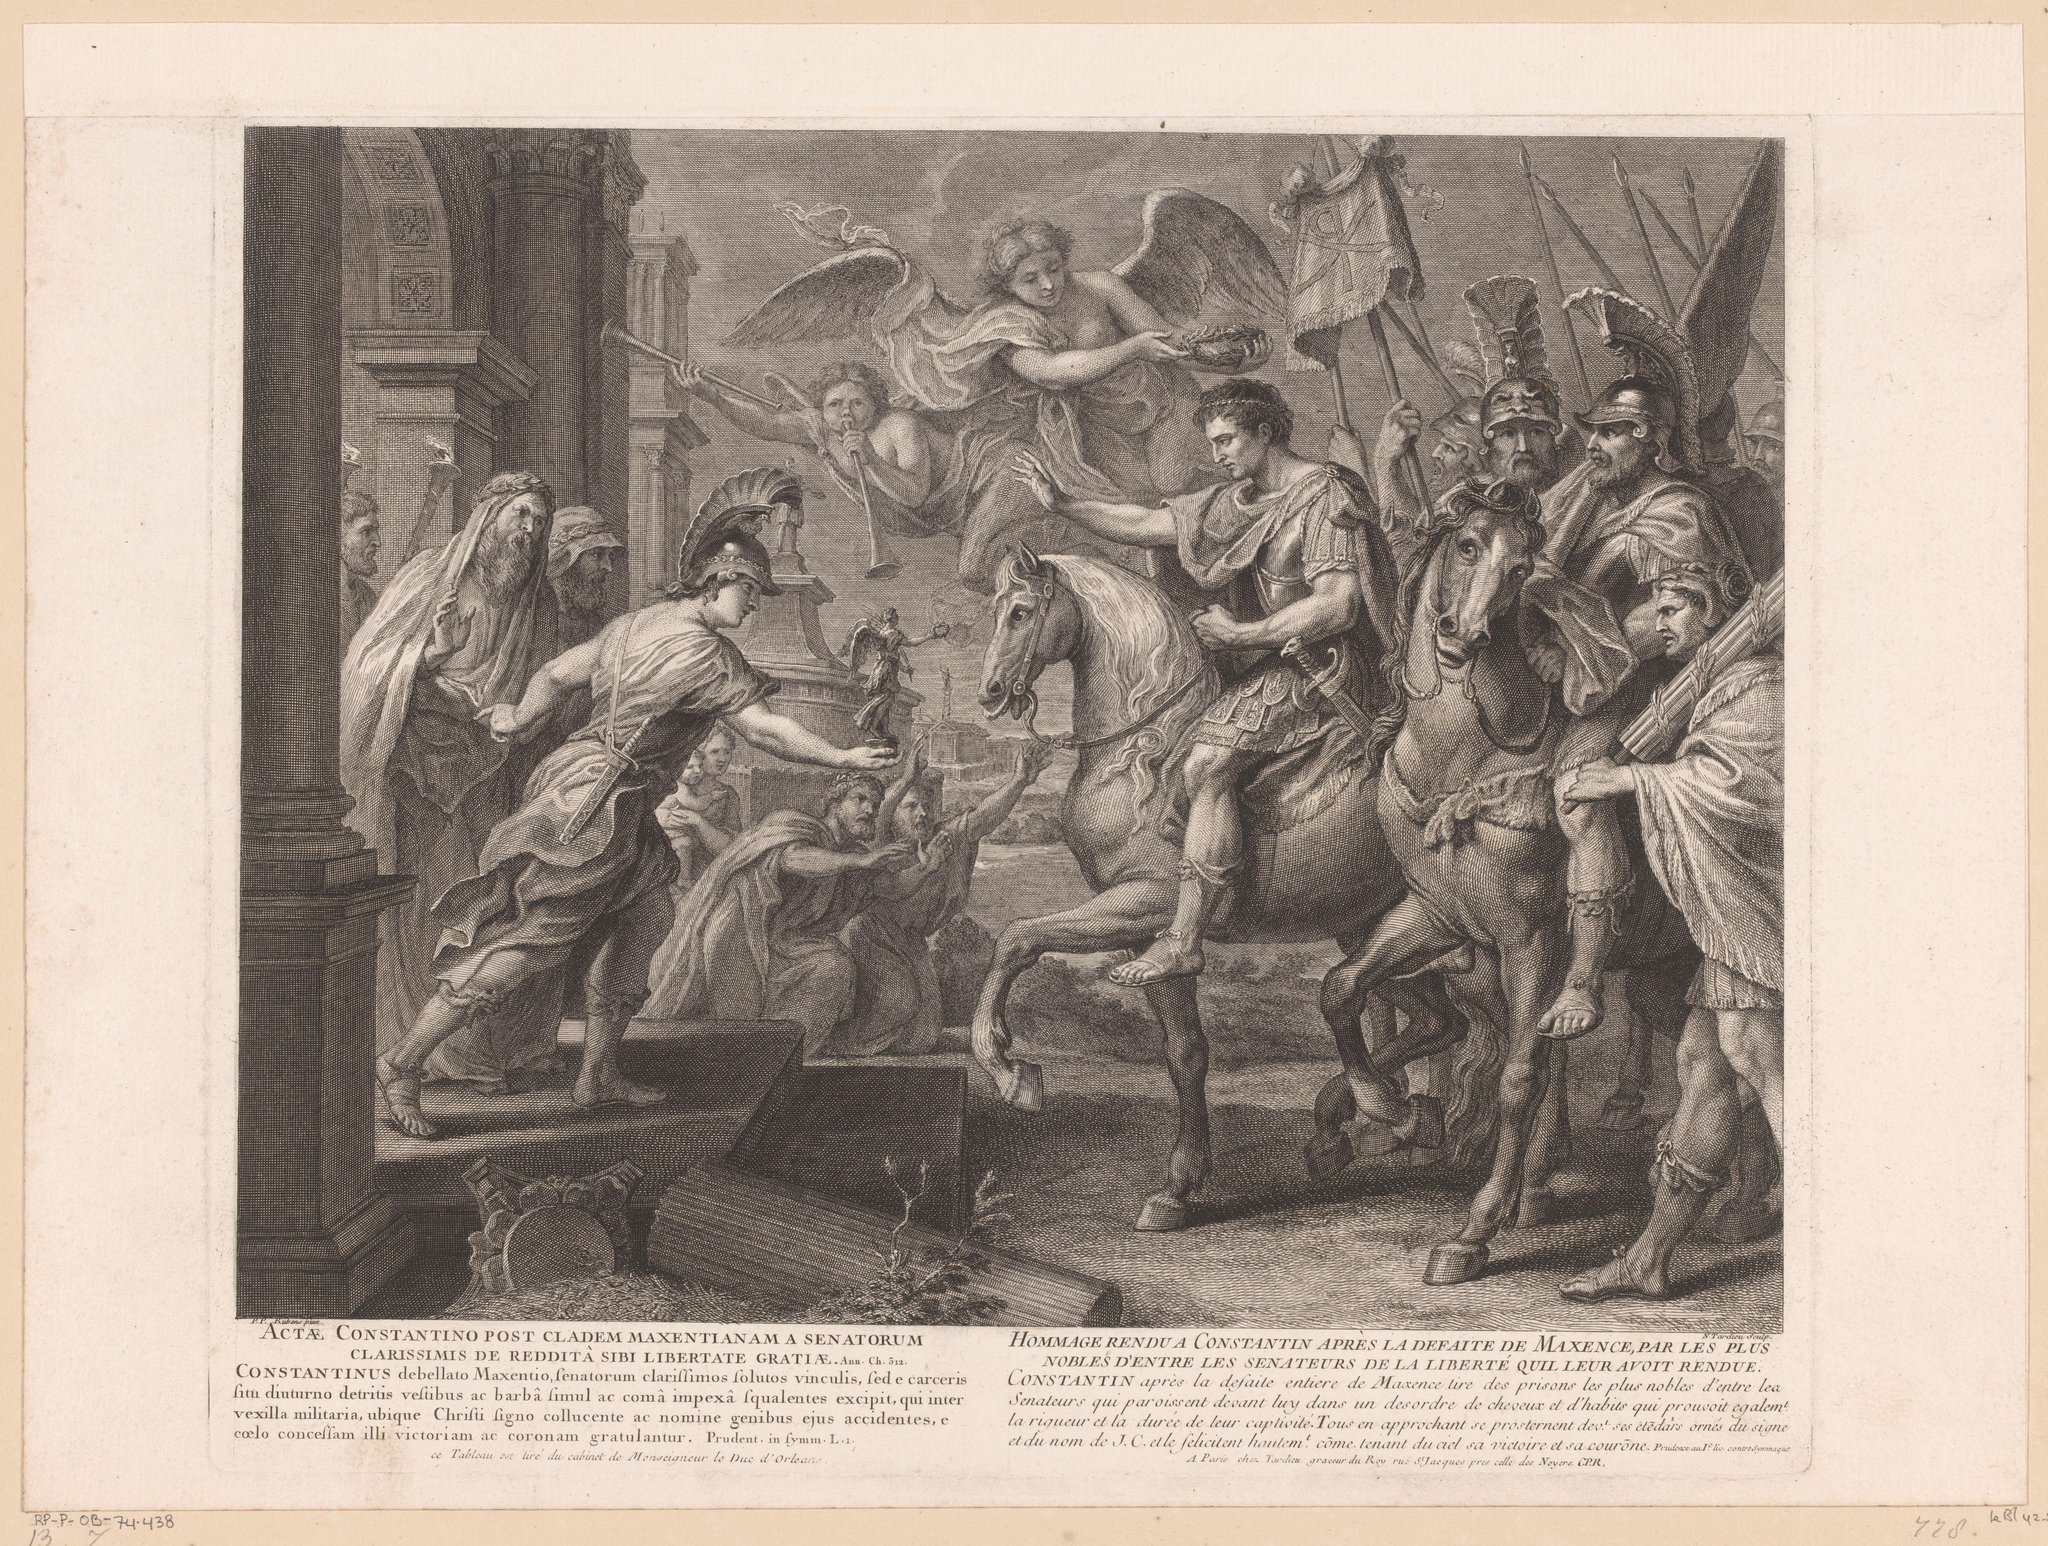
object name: print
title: Geschiedenis van keizer Constantijn de Grote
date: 1684-1749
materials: paper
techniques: engraving, etching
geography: paris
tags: victoria as roman personification, angels, the roman emperor constantine the great; possible attributes: crown, sceptre, standard (labarum) with chi-rho monogram or cross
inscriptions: collector's mark: Lugt 240